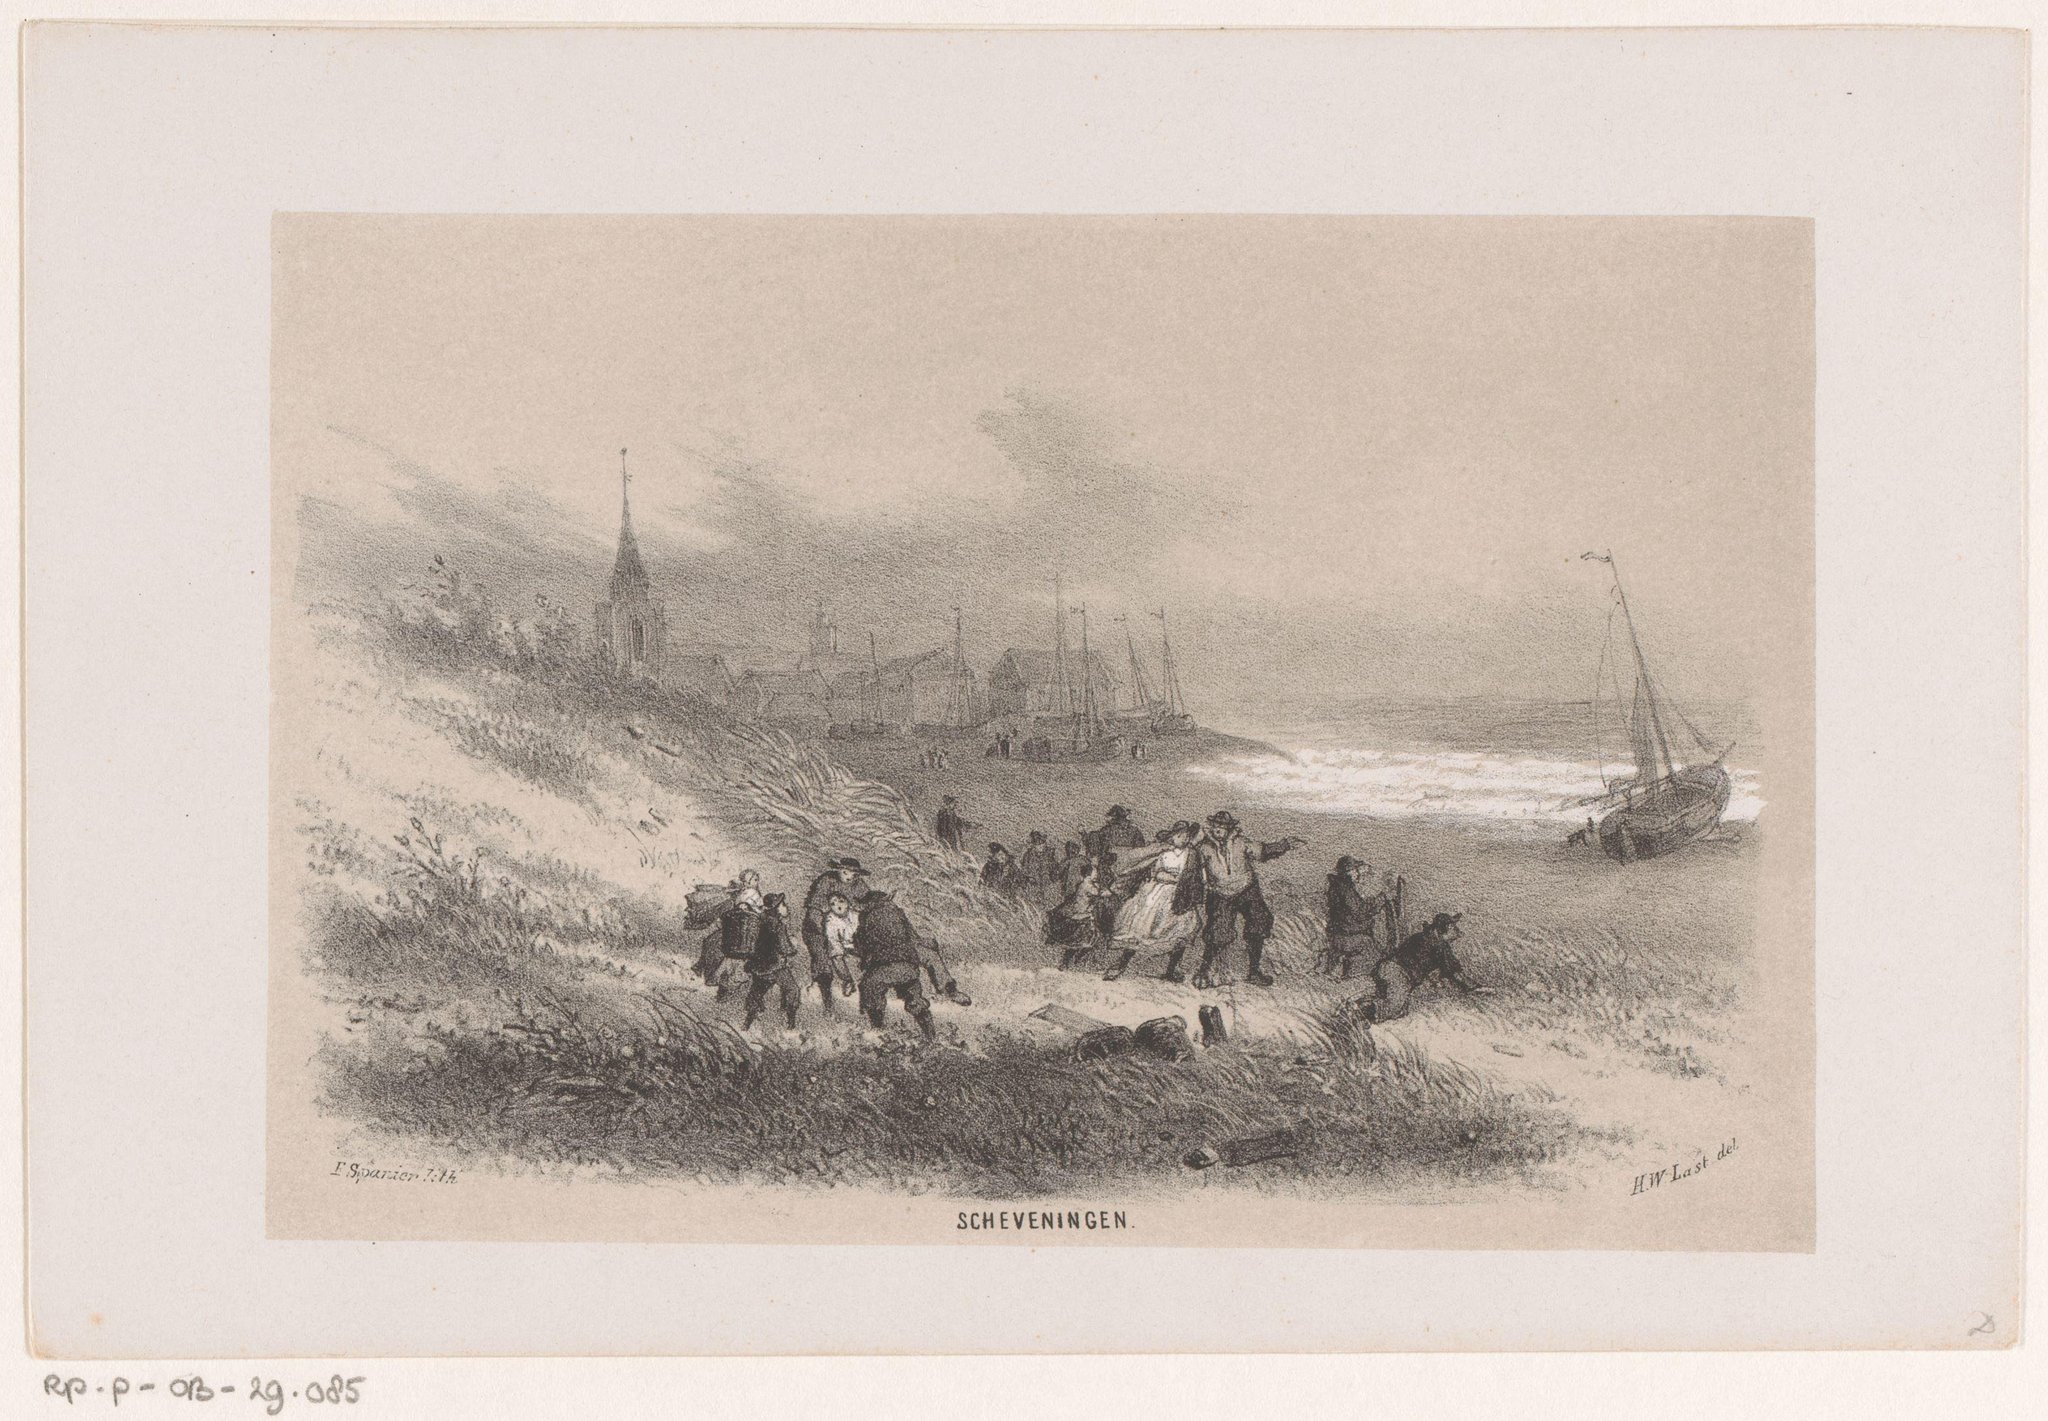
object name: print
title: Scheveningen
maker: m.m. couvée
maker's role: publisher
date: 1860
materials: paper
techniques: tone lithography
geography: the hague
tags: storm at sea, storm on land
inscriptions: collector's mark: Lugt 2228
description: Volk op de been in de duinen bij Scheveningen, tijdens de storm. Onderdeel van het album met tien losse steendrukken met voorstellingen van de schade aangericht door de 'Pinksterstorm' van 28 mei 1860 in het Haagse Bos en omgeving.